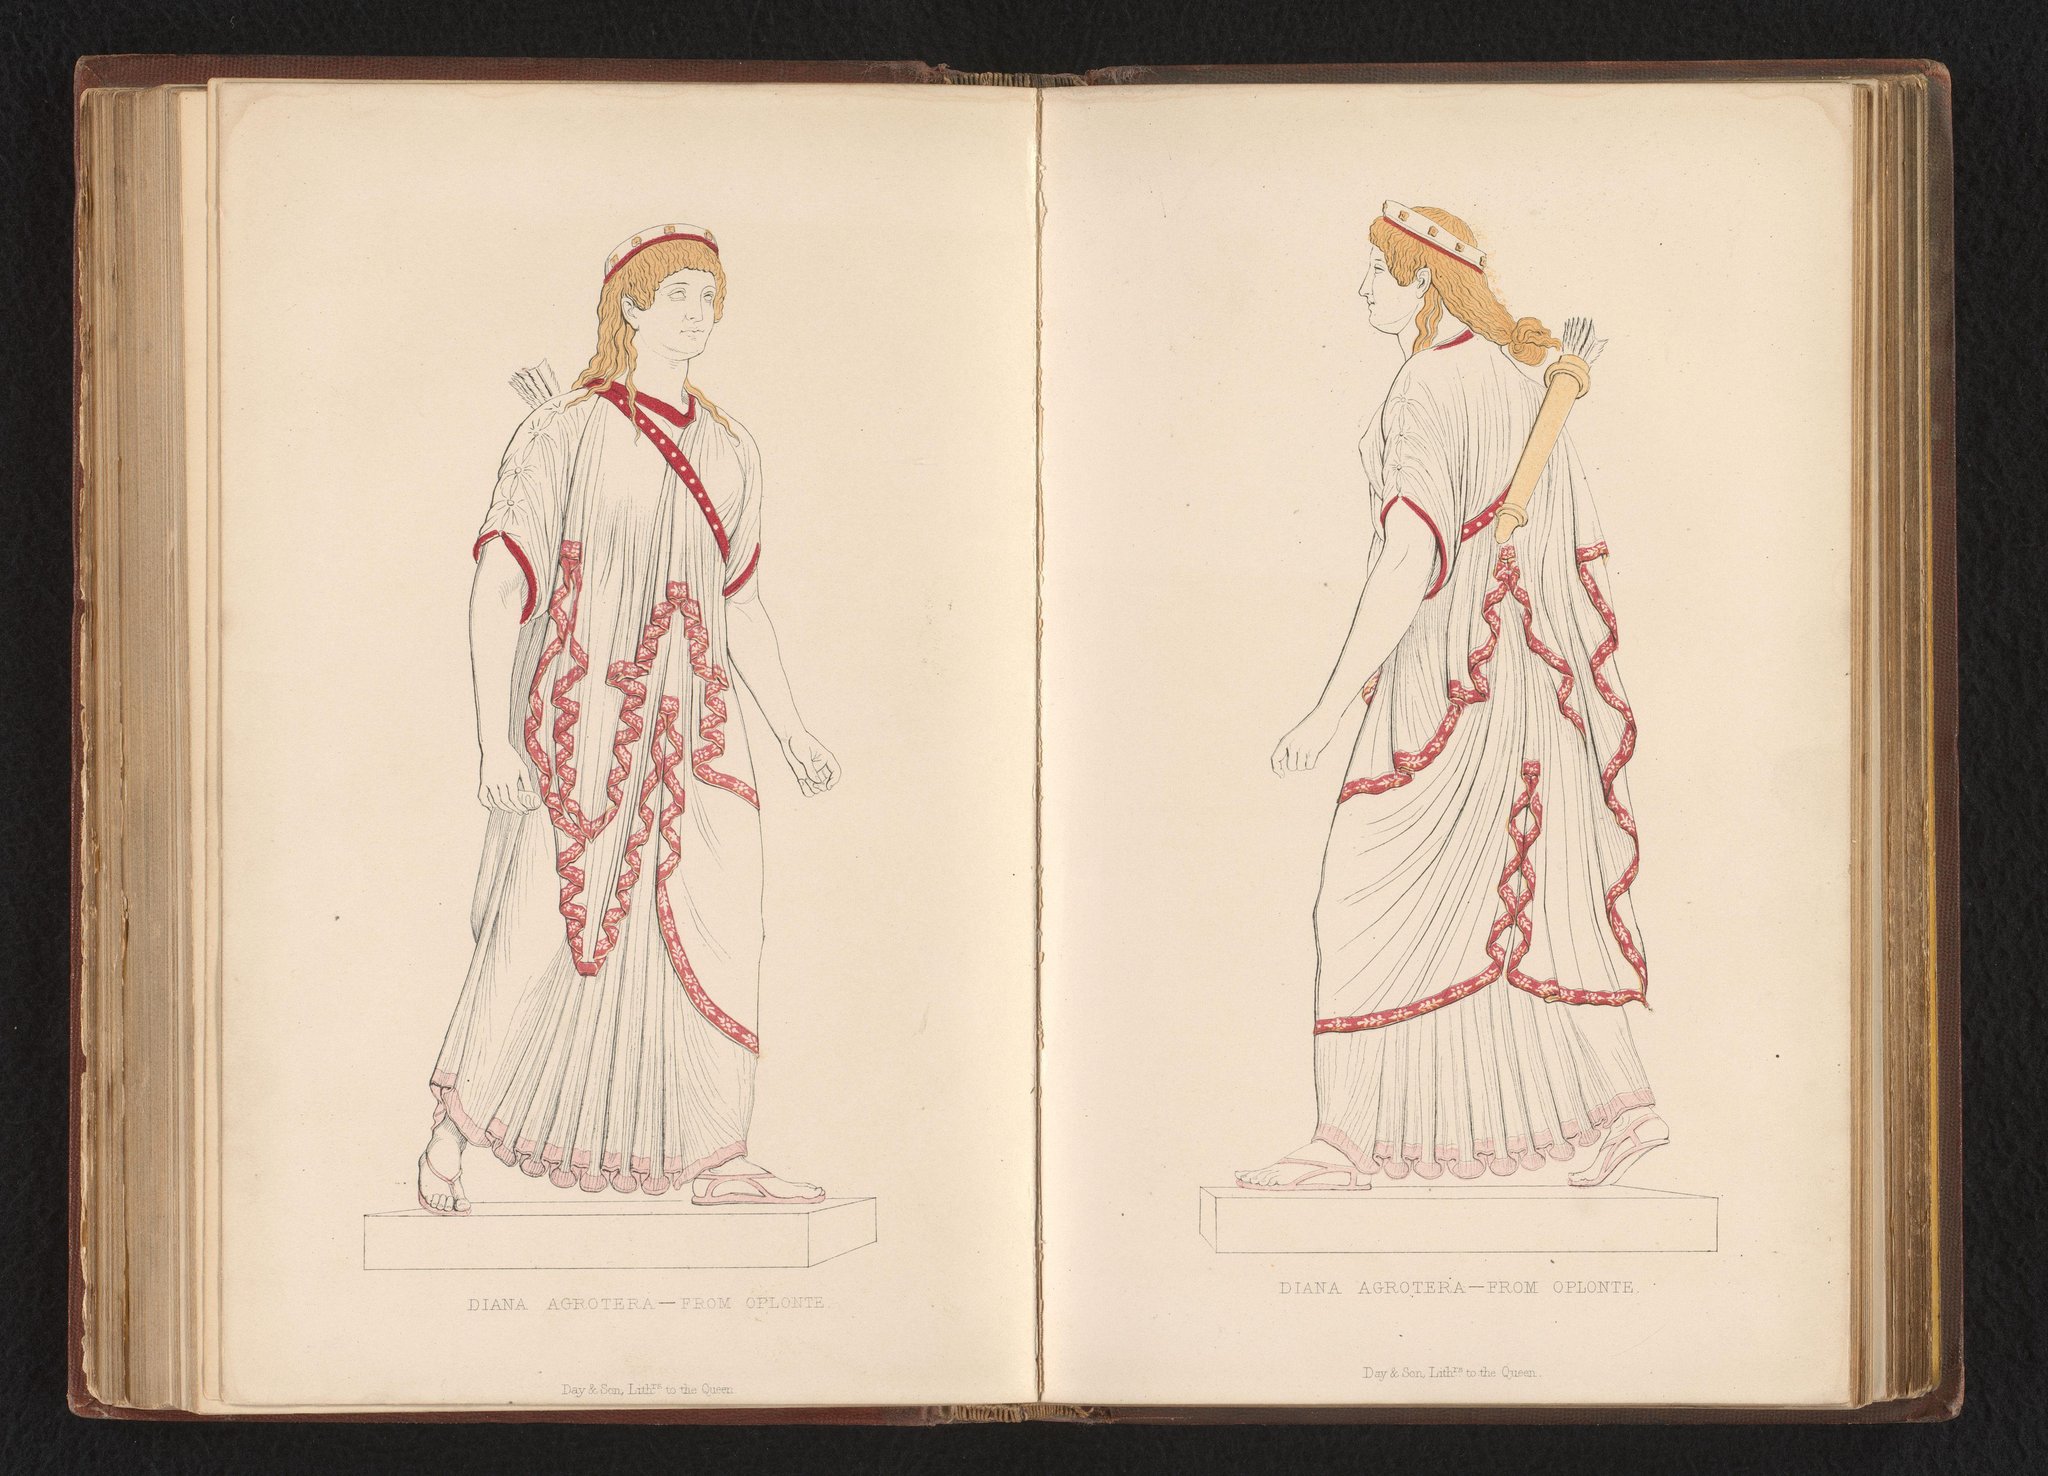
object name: print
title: Diana Agrotera, from Oplonte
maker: Anonymous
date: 1855-1860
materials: paper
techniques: lithograph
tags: (story of) diana (artemis)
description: Prent op tweede ongenummerde pagina na pagina 142.